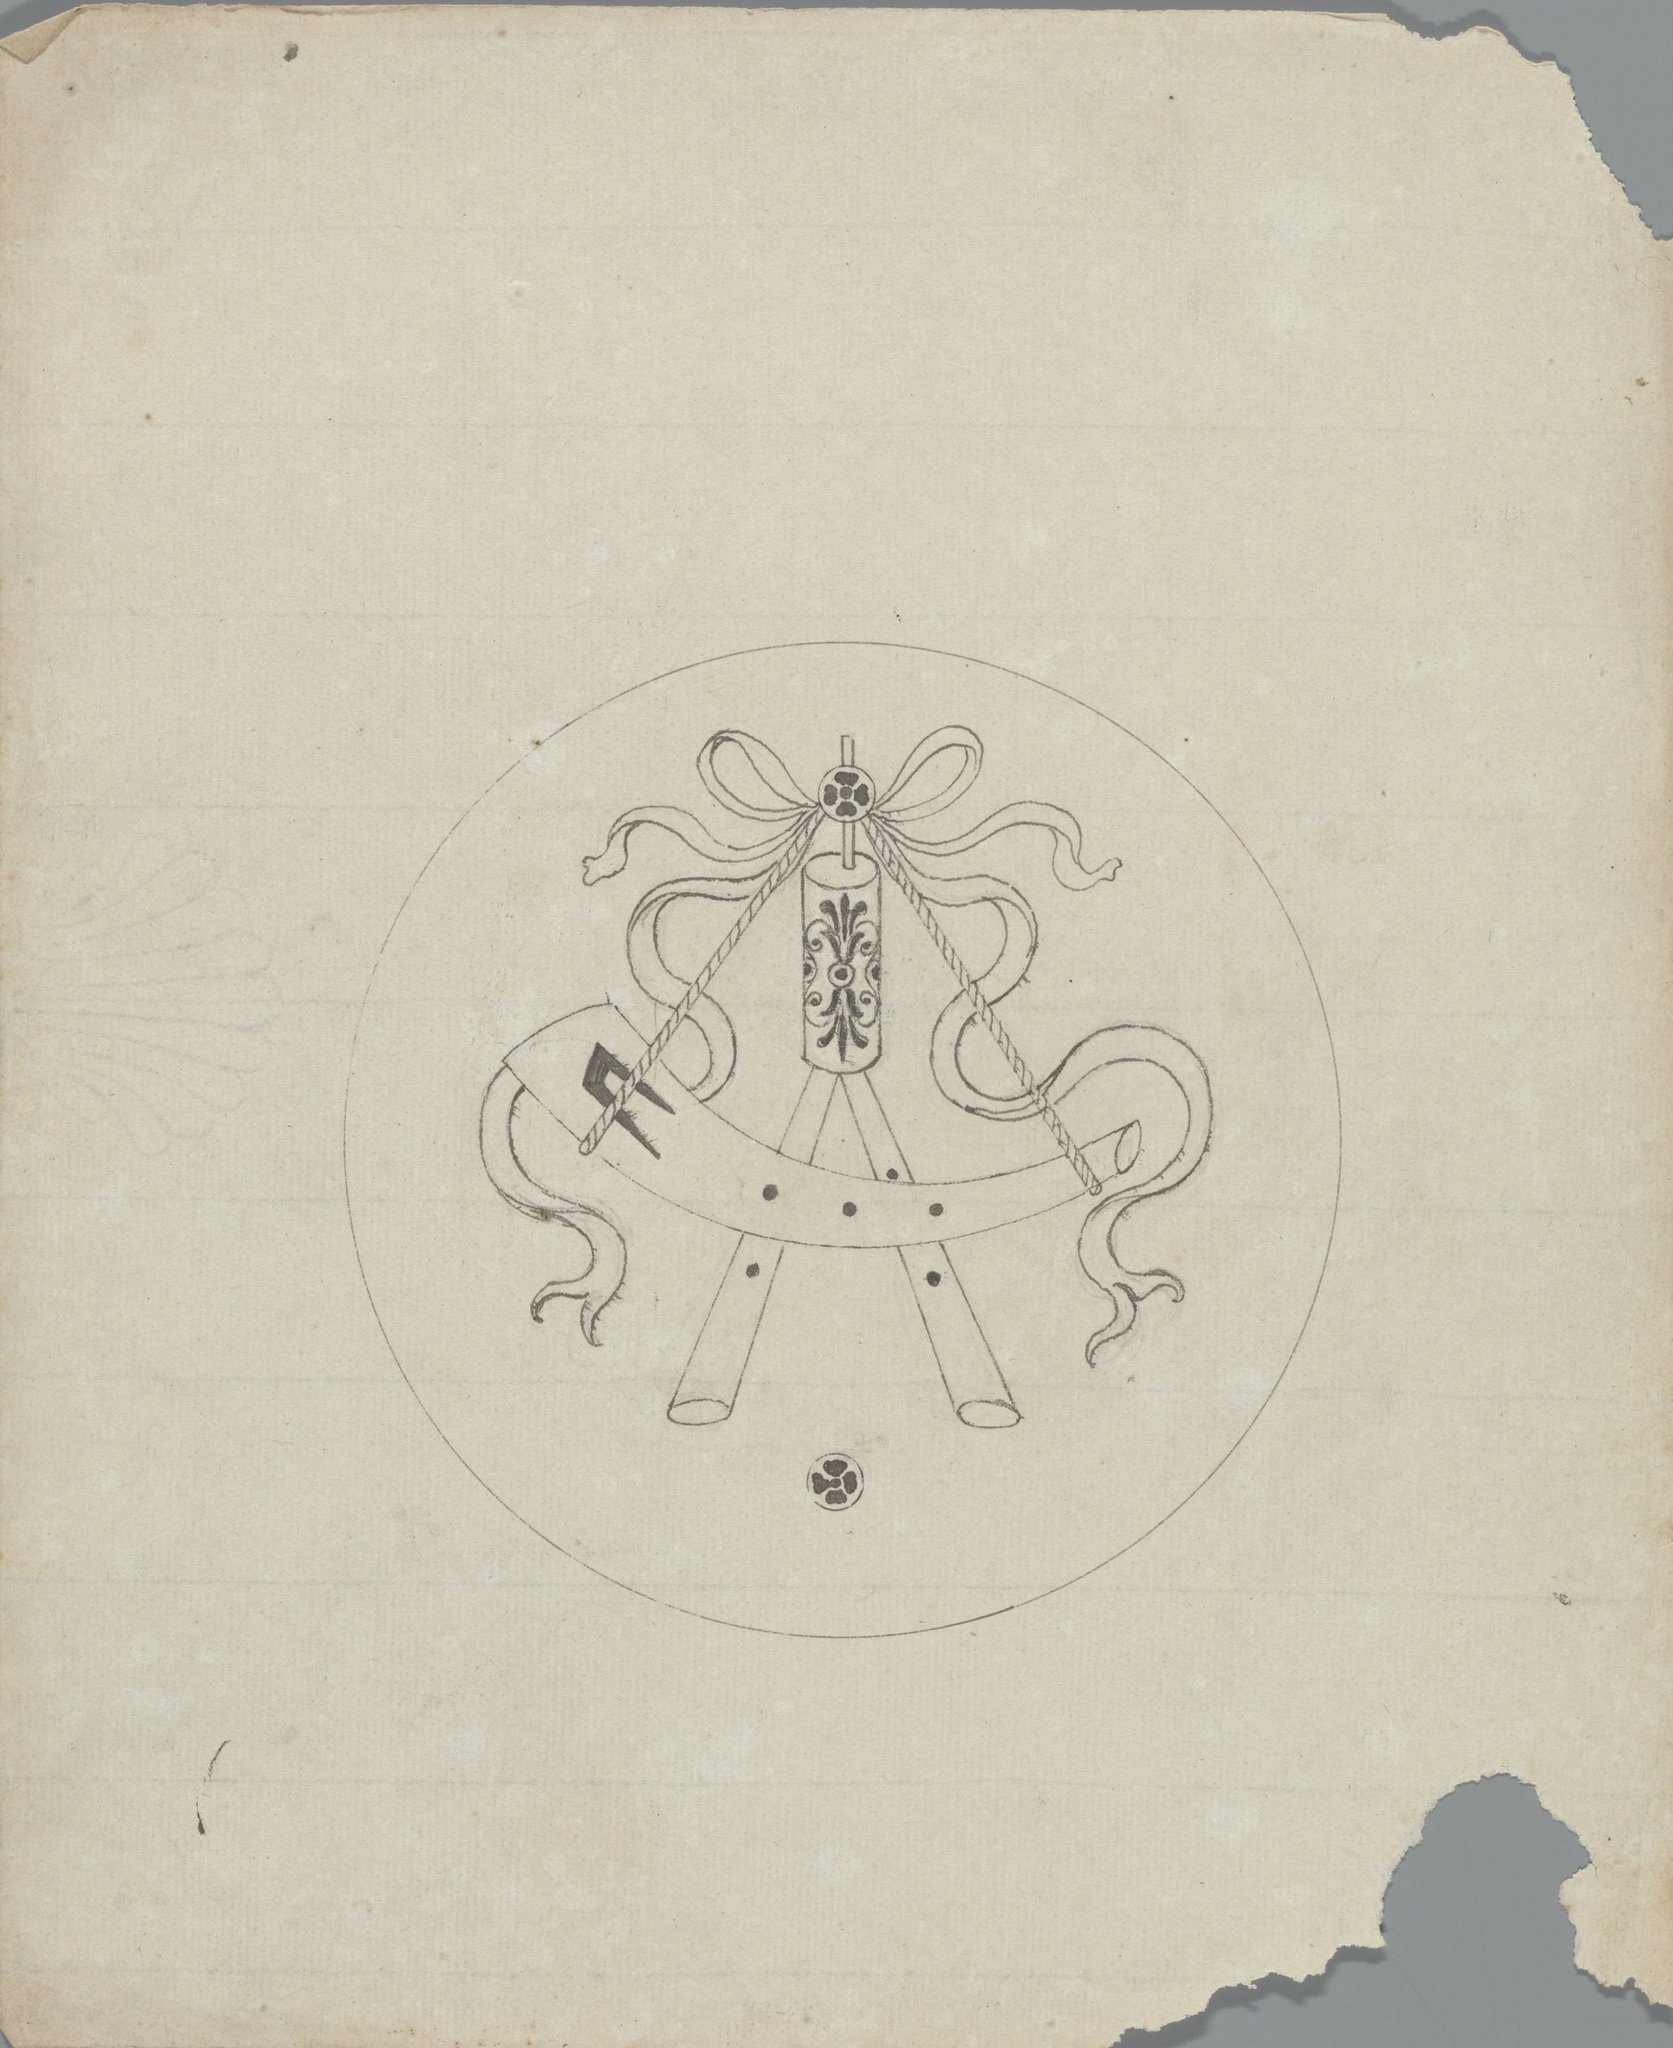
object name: design drawing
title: Ontwerp voor marqueterie van aan linten opgehangen muziekinstrument(en) in rond medaillon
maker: pierre félix van doren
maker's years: 1797-1856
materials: graphite, ink, paper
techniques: pen in black ink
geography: brussels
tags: trophy, i.e.: decorative arrangement of symbolic or typical objects ~ ornament, wind instruments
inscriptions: watermark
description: Een van 103 ontwerpen voor marqueterie van aan linten opgehangen muziekinstrumenten in ronde medaillons, bestemd voor de set stoelen gemaakt door Van Doren voor de grote zaal van het Paleis van de Prins van Oranje in Brussel in 1828.